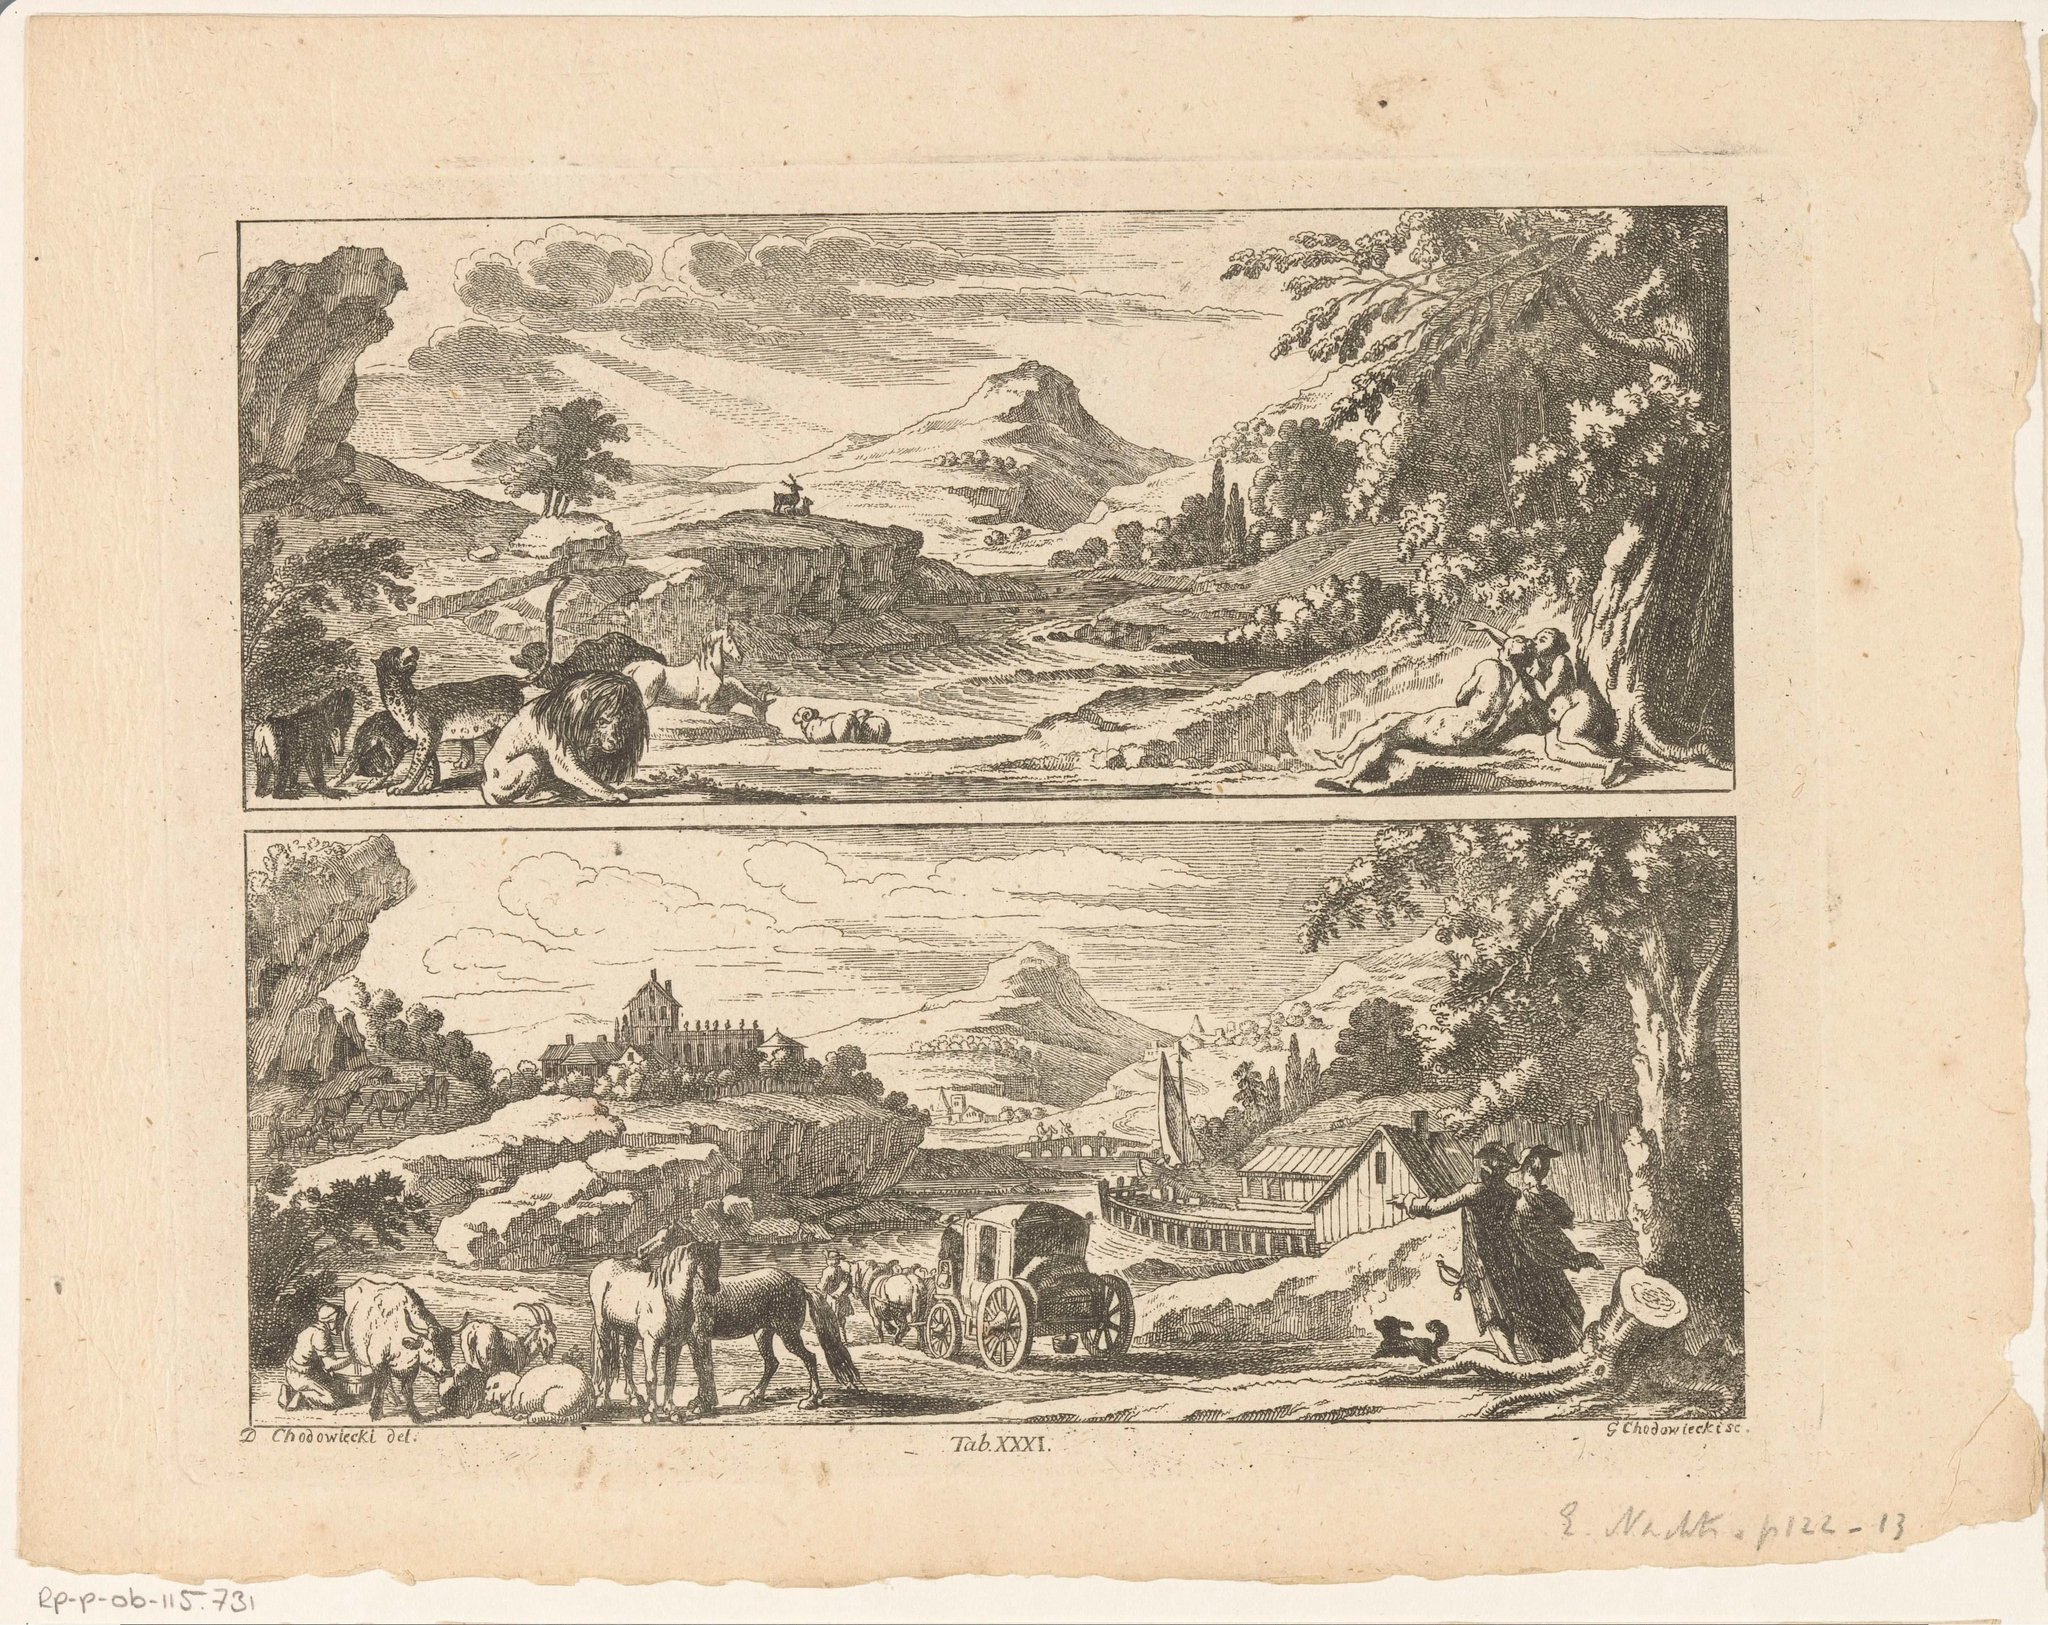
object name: print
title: Twee voorstellingen over de menselijke invloed op het landschap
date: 1774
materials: paper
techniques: etching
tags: traffic and transport, cattle, man and (wild) animal, civic architecture; edifices; dwellings, landscapes - hh - ideal landscapes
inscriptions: collector's mark: Lugt 2228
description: Prent uit: Basedow, Johann Bernhard. Kupfersammlung zu J.B. Basedows Elementarwerke für die Jugend und ihre Freunde (...). Berlijn en Dessau: s.n., 1774.